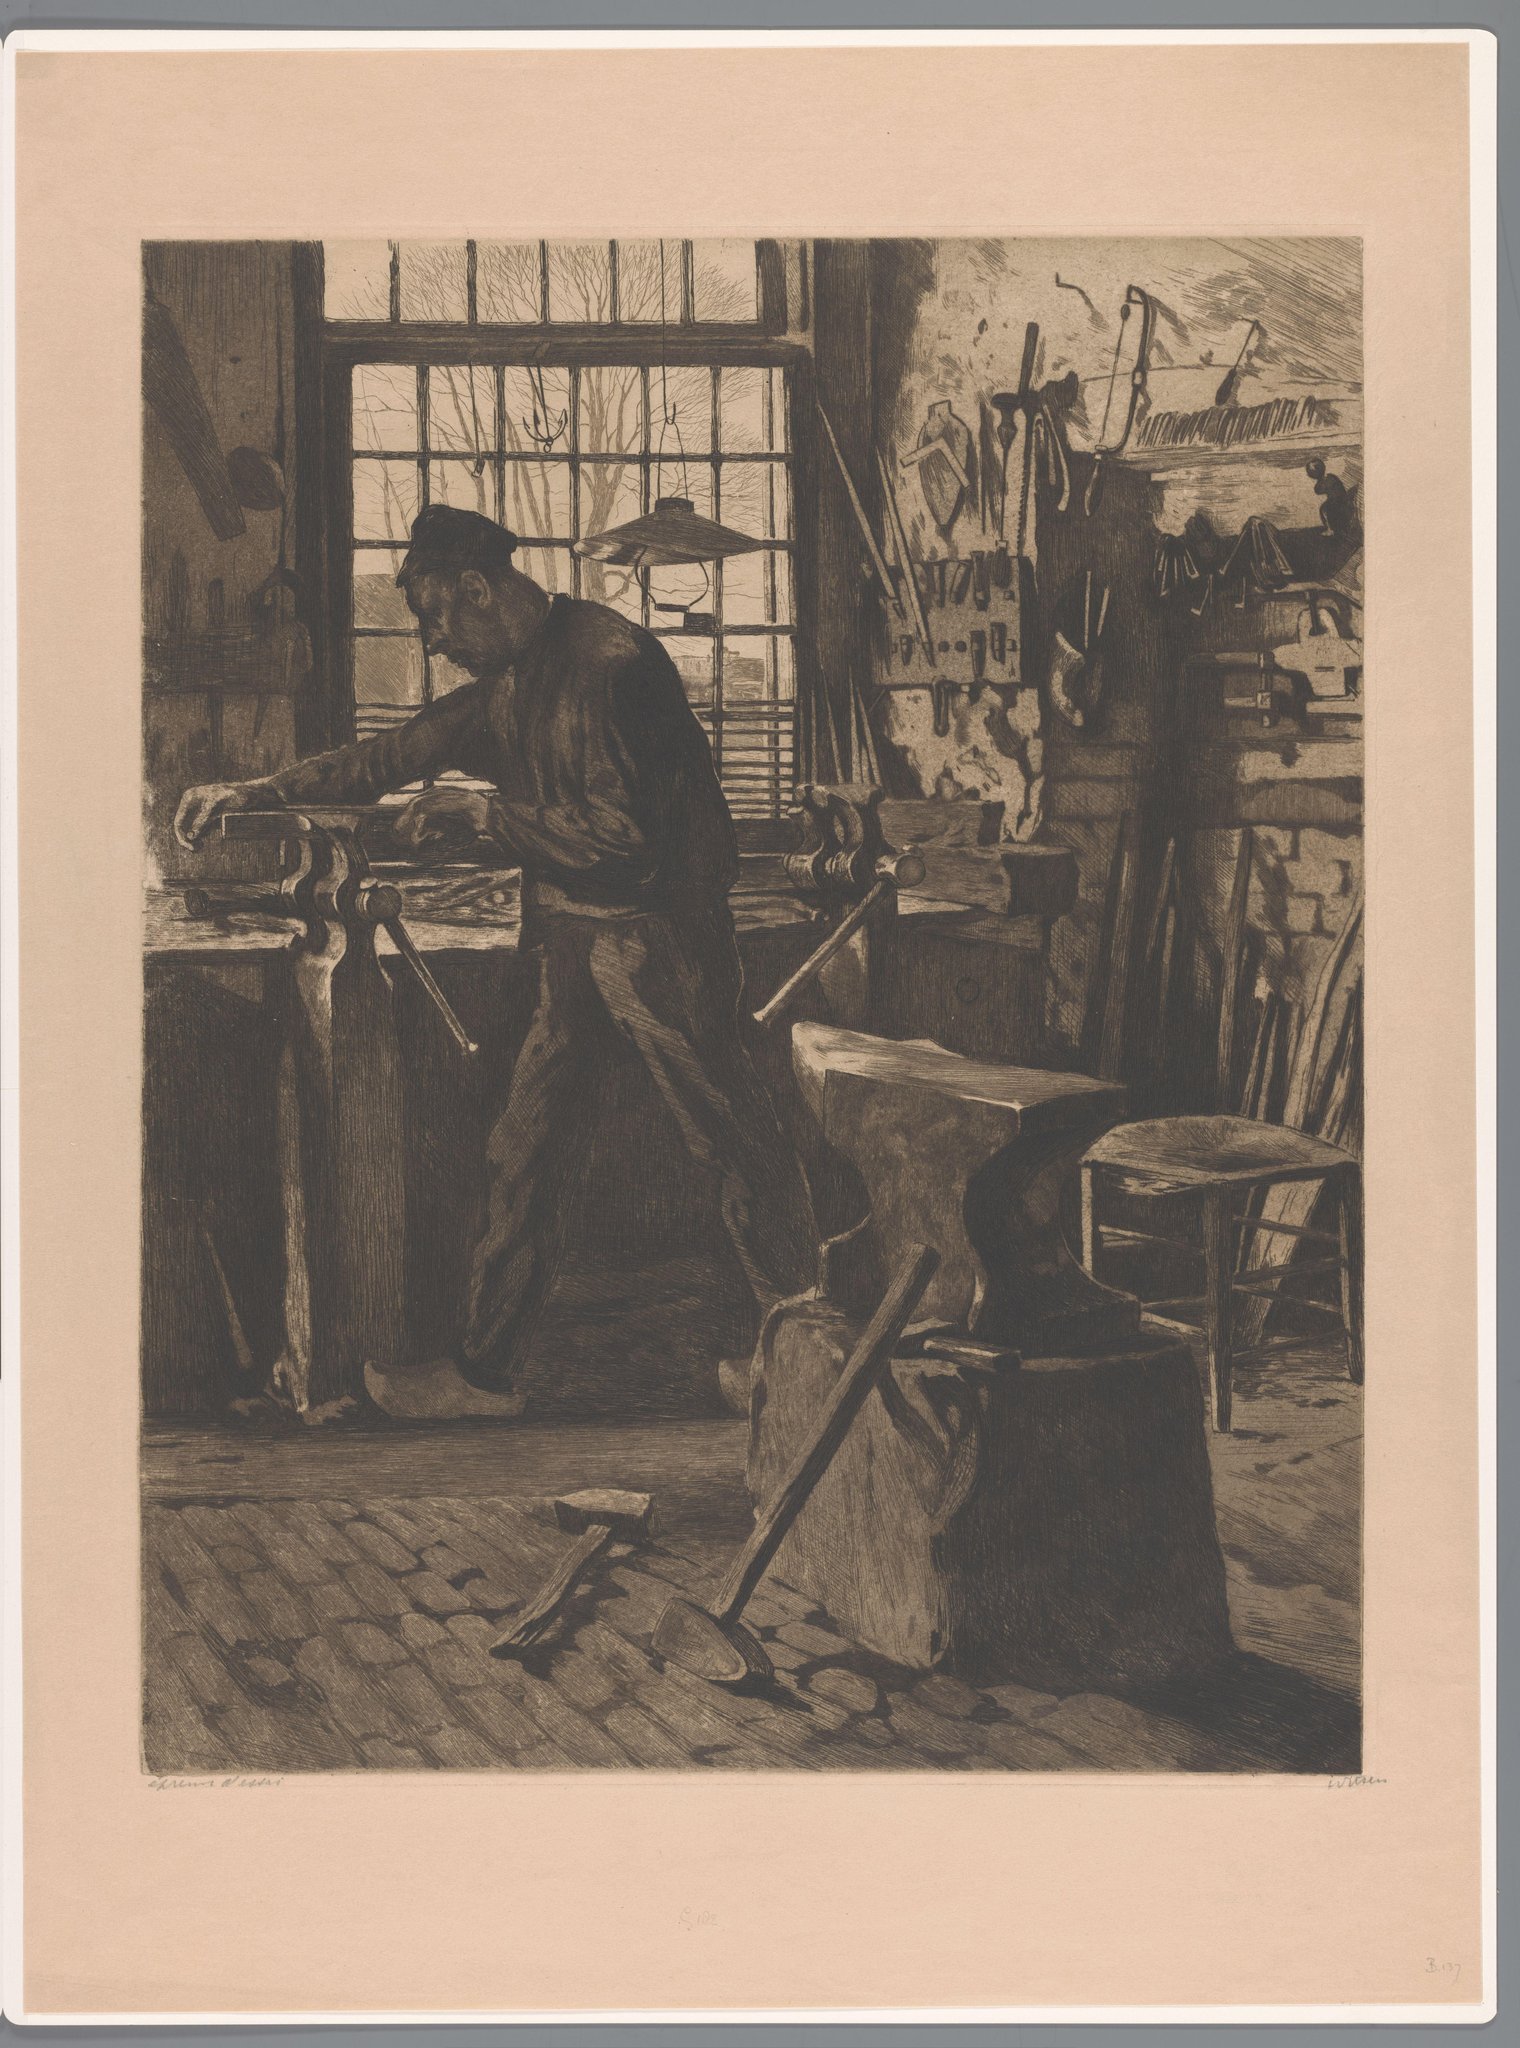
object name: print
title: Smid aan het werk bij een bankschroef bij het raam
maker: willem witsen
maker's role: draughtsman, painter, print maker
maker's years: 1860-1923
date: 1908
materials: paper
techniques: aquatint, etching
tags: smith, blacksmith (+ men (labourers)), tools, aids, implements ~ crafts and industries: vice, wijk bij duurstede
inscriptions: annotation: ‘épreuve d'essai’